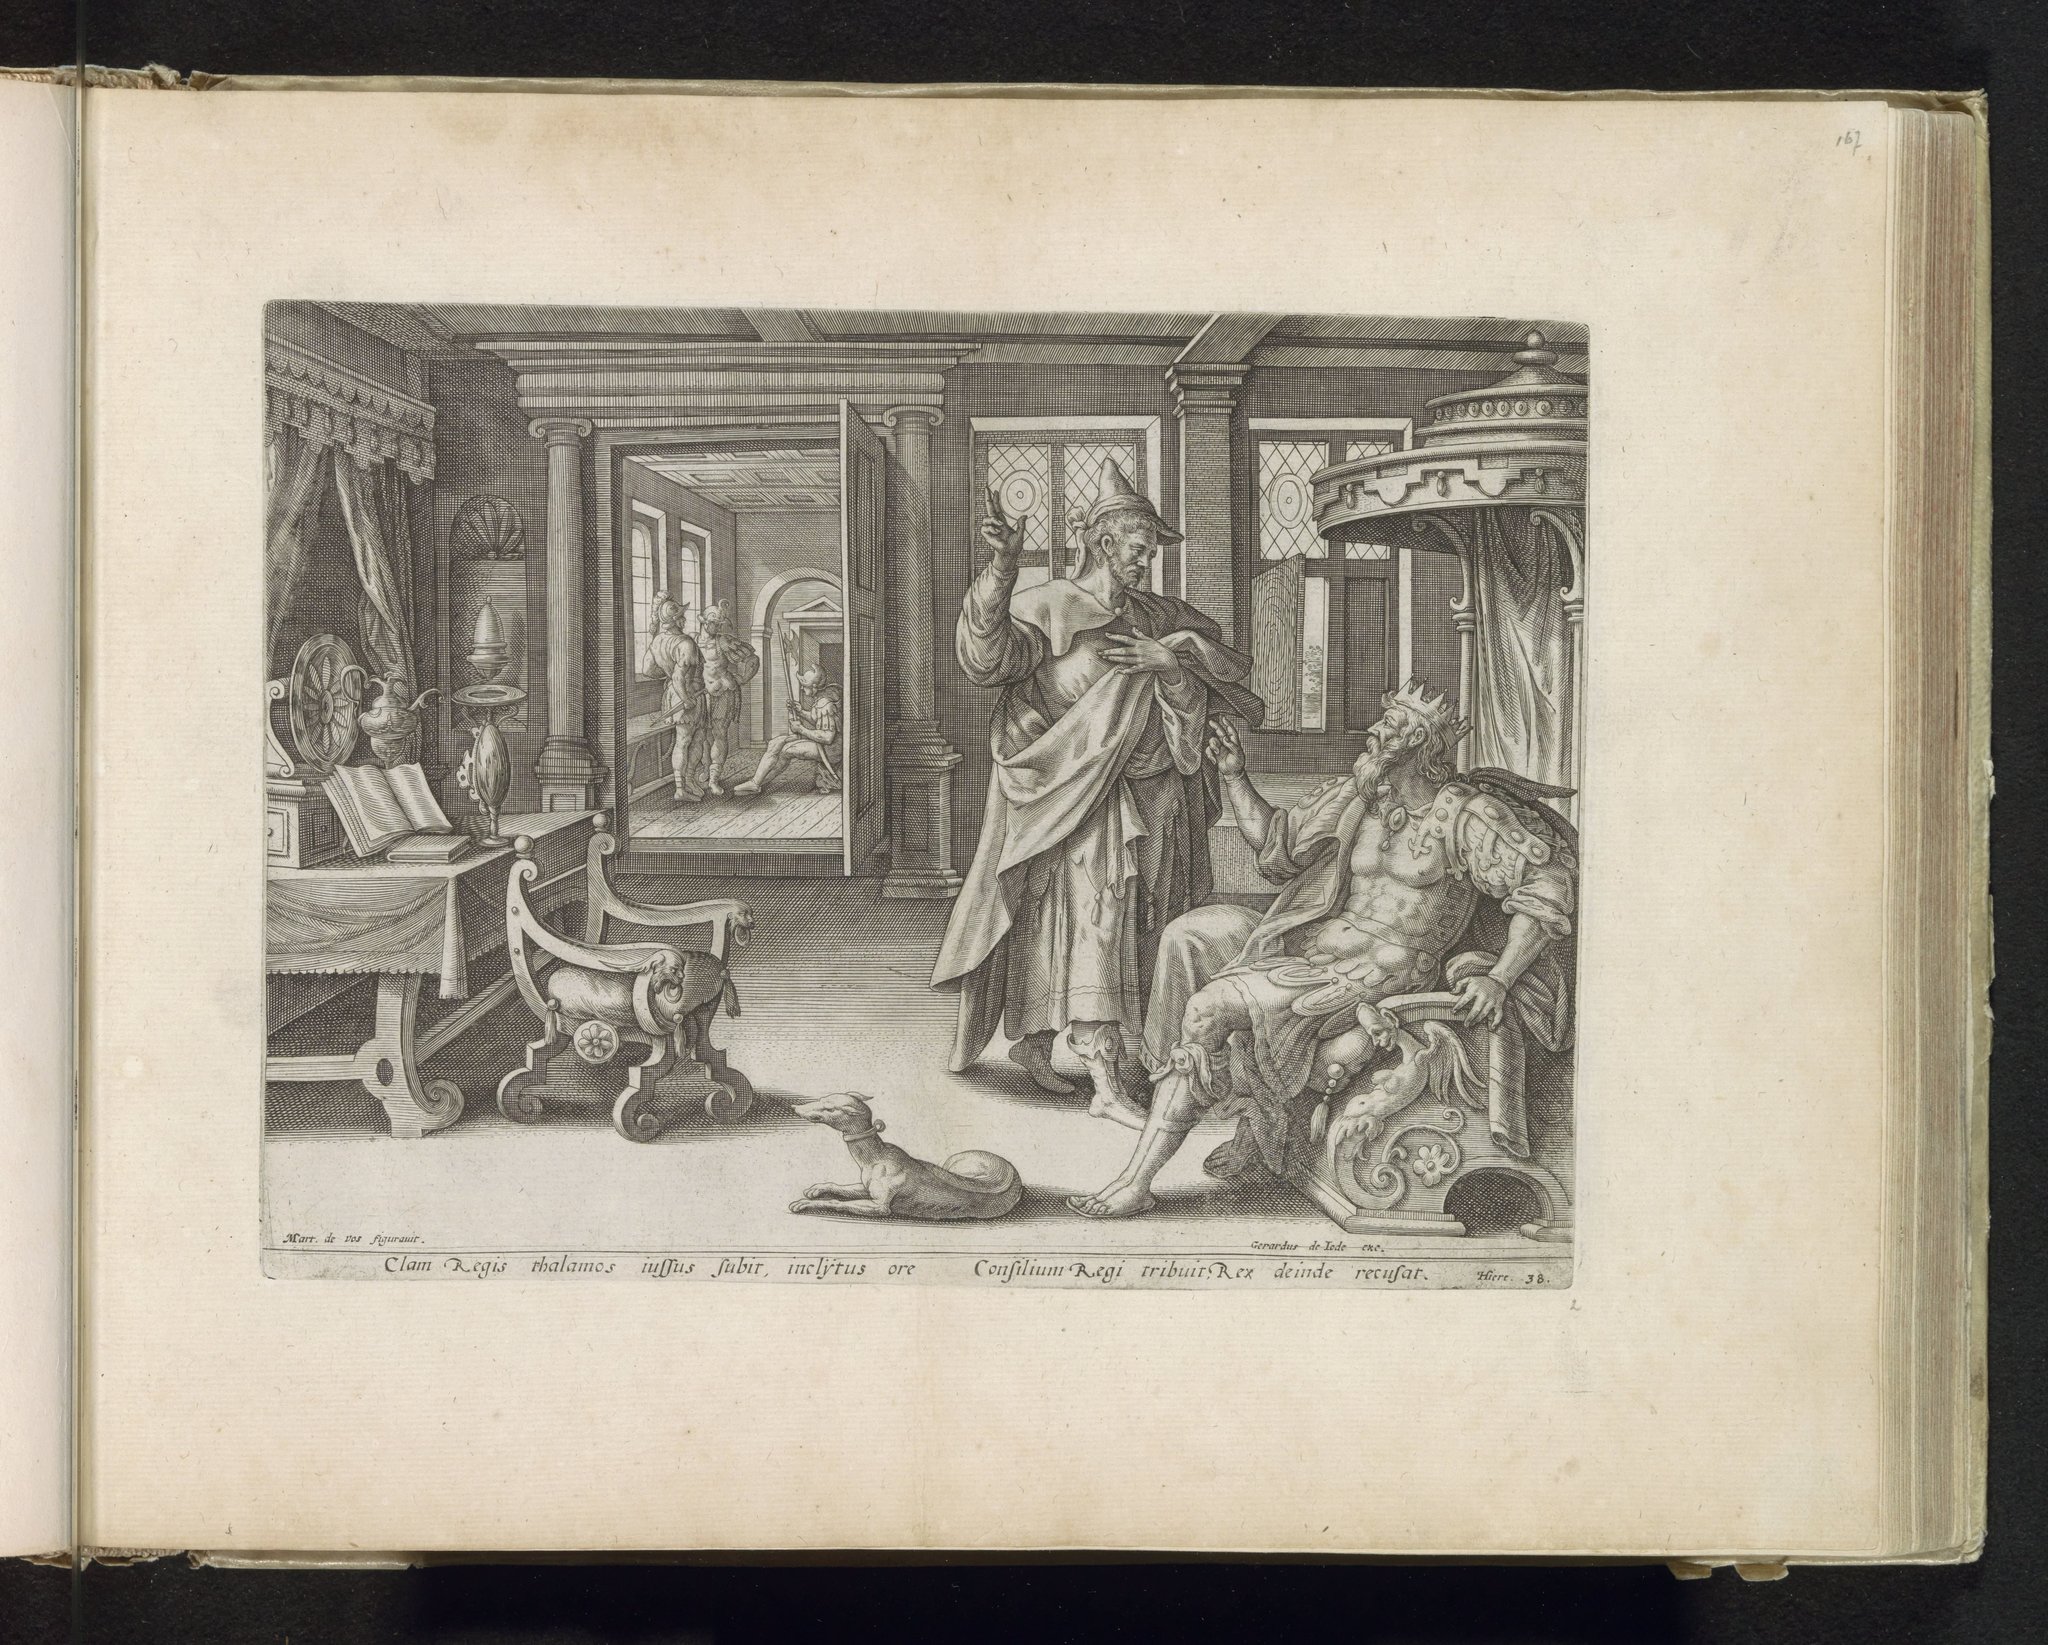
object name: print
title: Geschiedenis van Jeremia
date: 1585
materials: paper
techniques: engraving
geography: antwerp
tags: jeremiah before zedekiah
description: Koning Sedekia vraagt aan Jeremia wat God aan hem heeft geopenbaard. Onder de voorstelling een verwijzing in het Latijn naar de Bijbeltekst in Jer. 38. Deze prent maakt deel uit van een album.